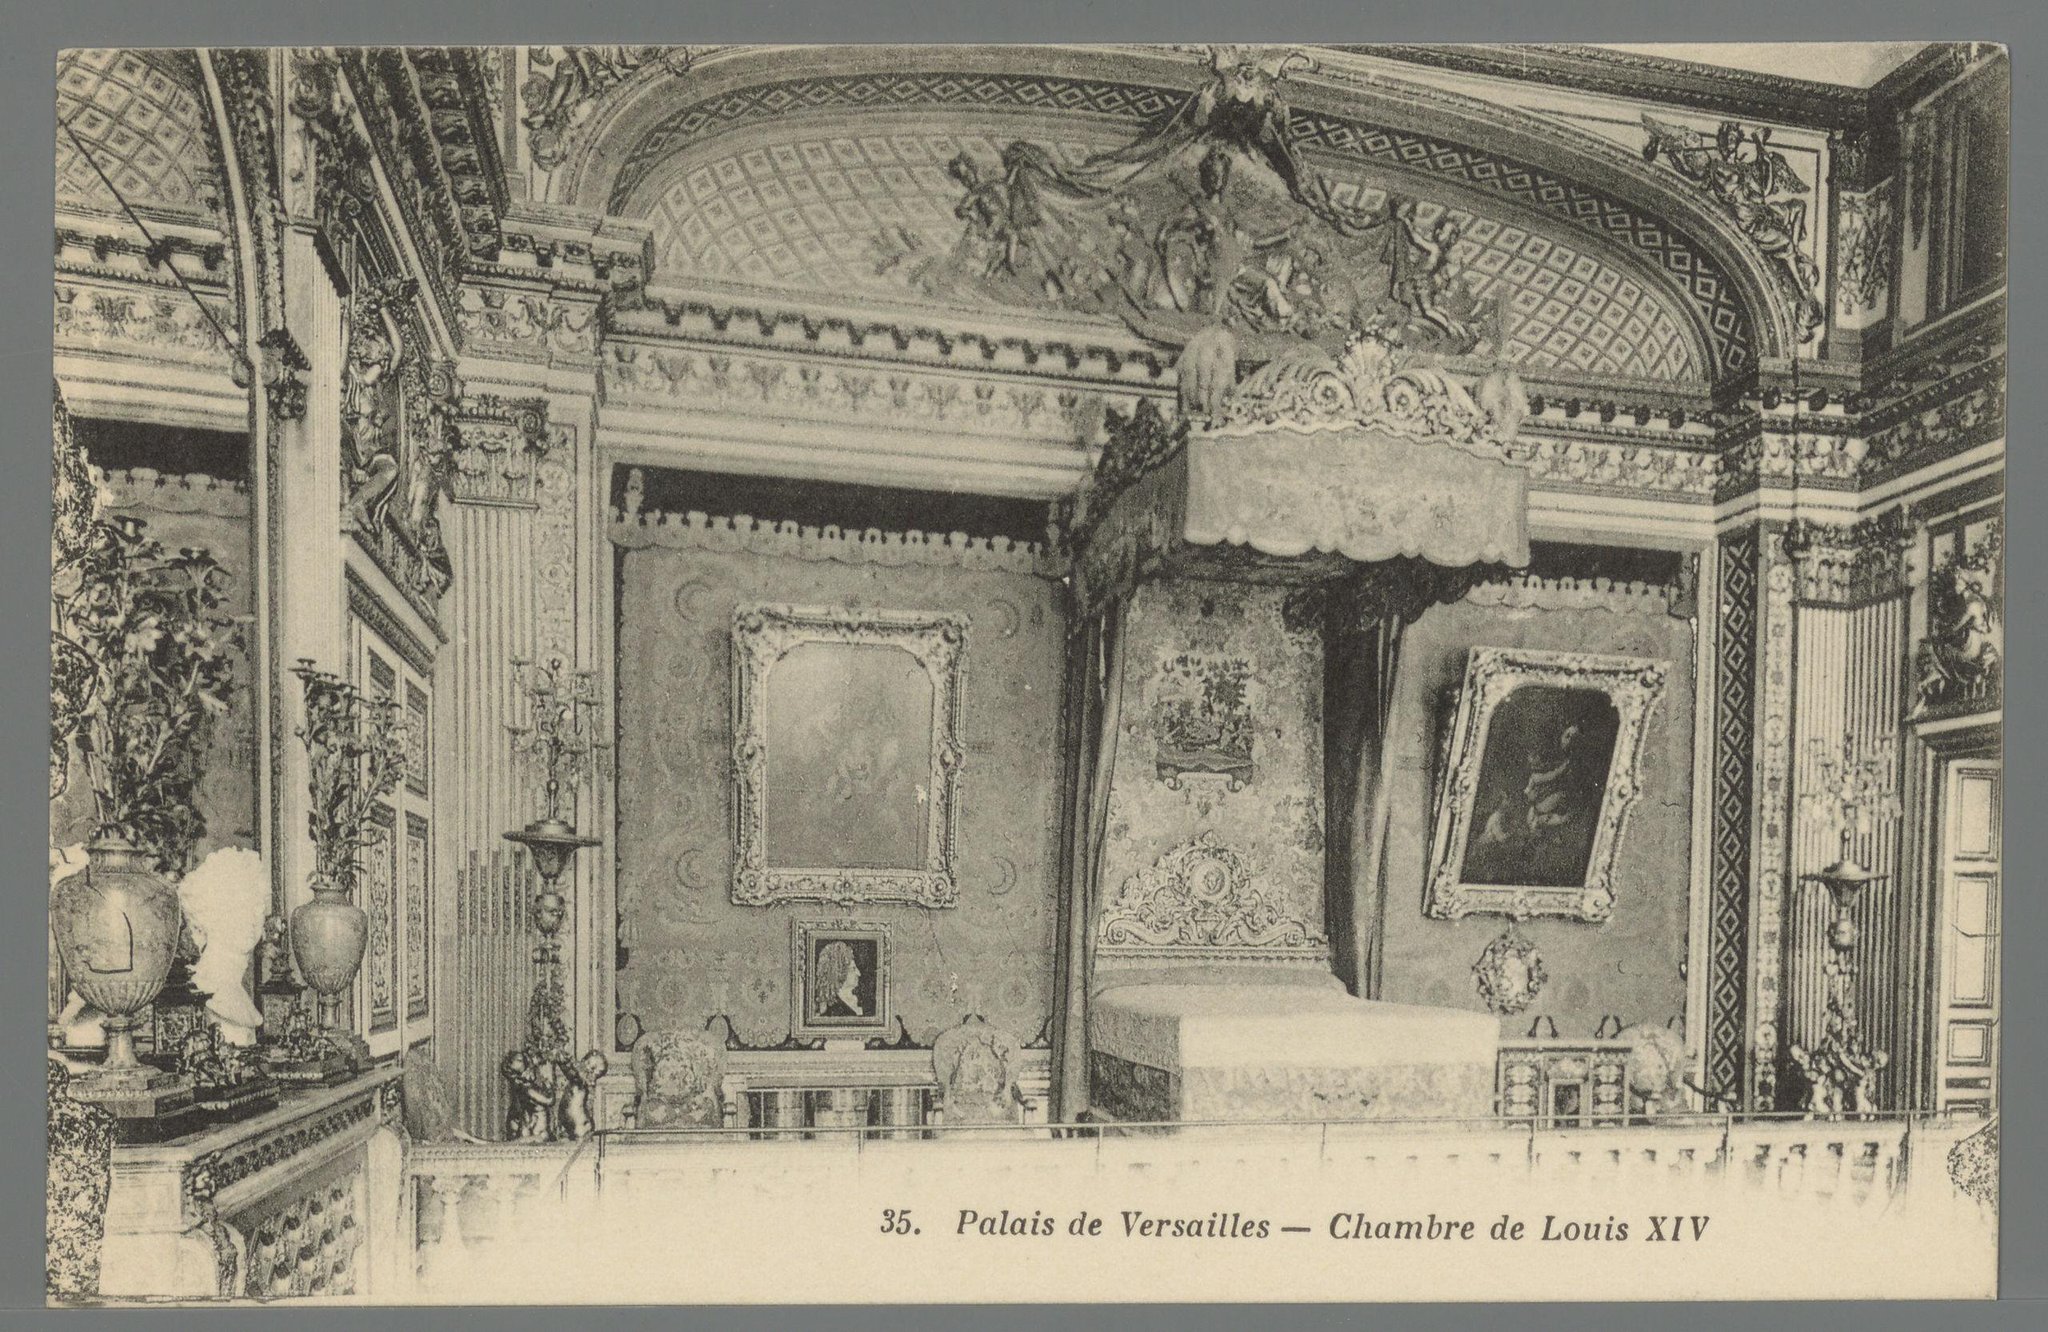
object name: photomechanical print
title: Palais de Versailles. Chambre de Louis XIV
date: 1903-1920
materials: cardboard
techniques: photograph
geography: versailles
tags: palace, interior ~ representation of a building, bedroom